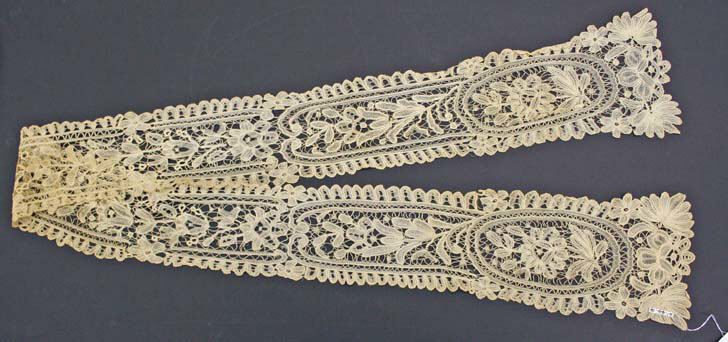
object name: scarf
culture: american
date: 1700-1941